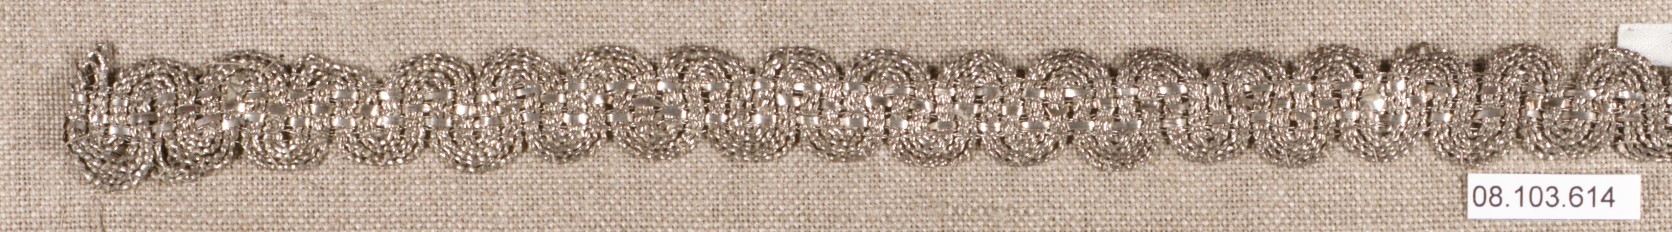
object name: galloon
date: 1701-1800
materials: metal thread, silk